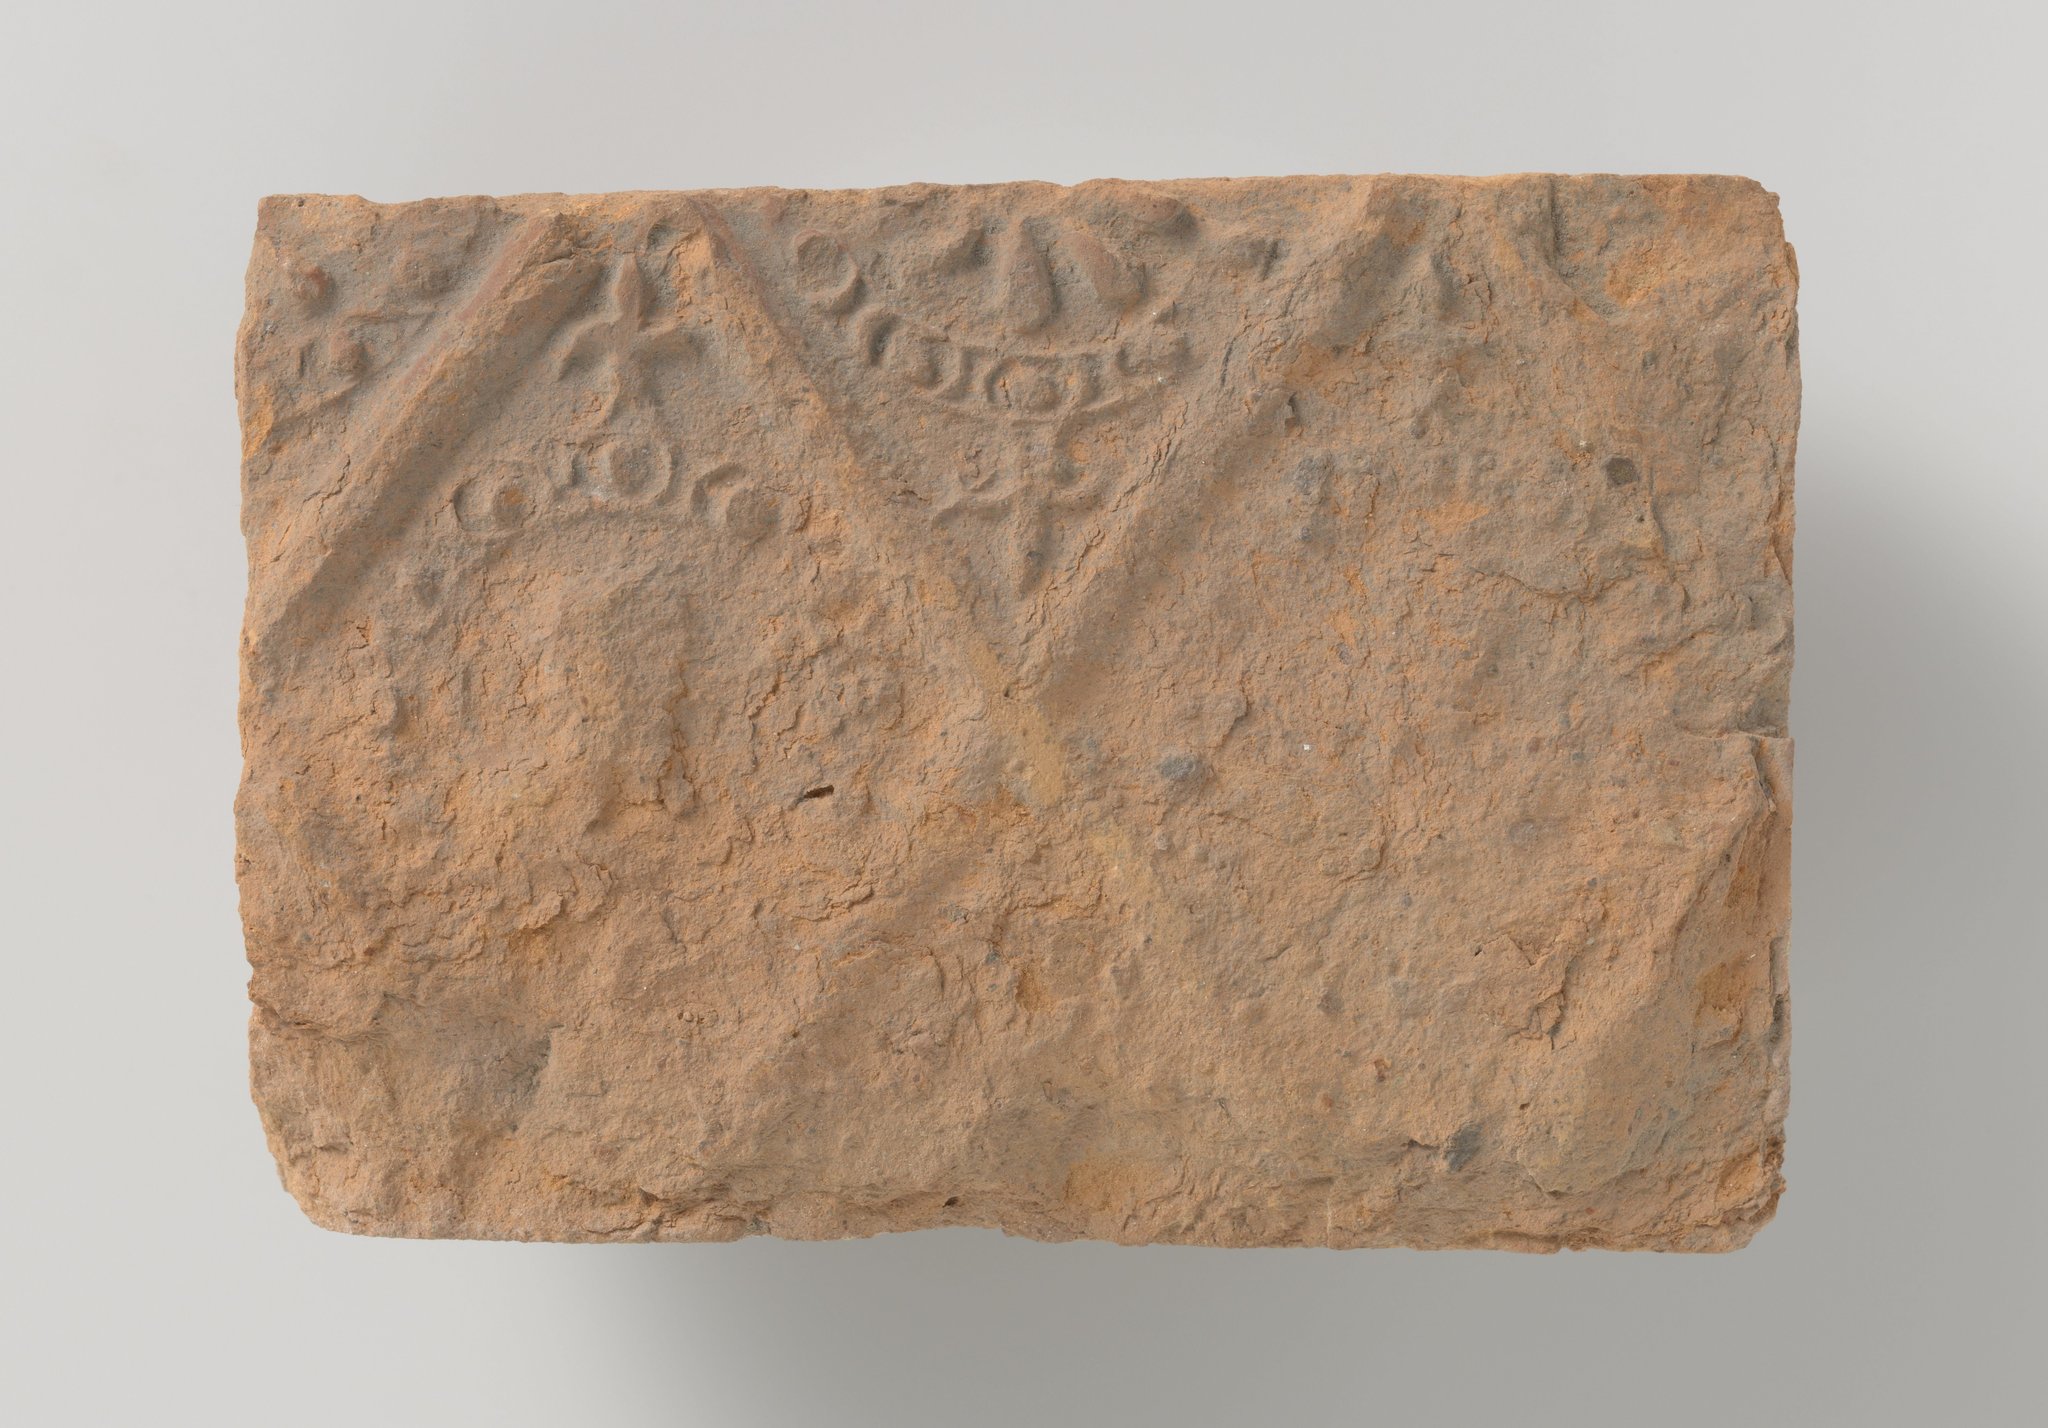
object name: hearthstone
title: Haardsteen met afbeelding van een mannen- en een vrouwenkop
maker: Anonymous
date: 1587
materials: earthenware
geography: southern netherlands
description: Haardsteen van gebakken aarde met twee vorstelijke busten; een man en een vrouw. Met het jaartal 1587.